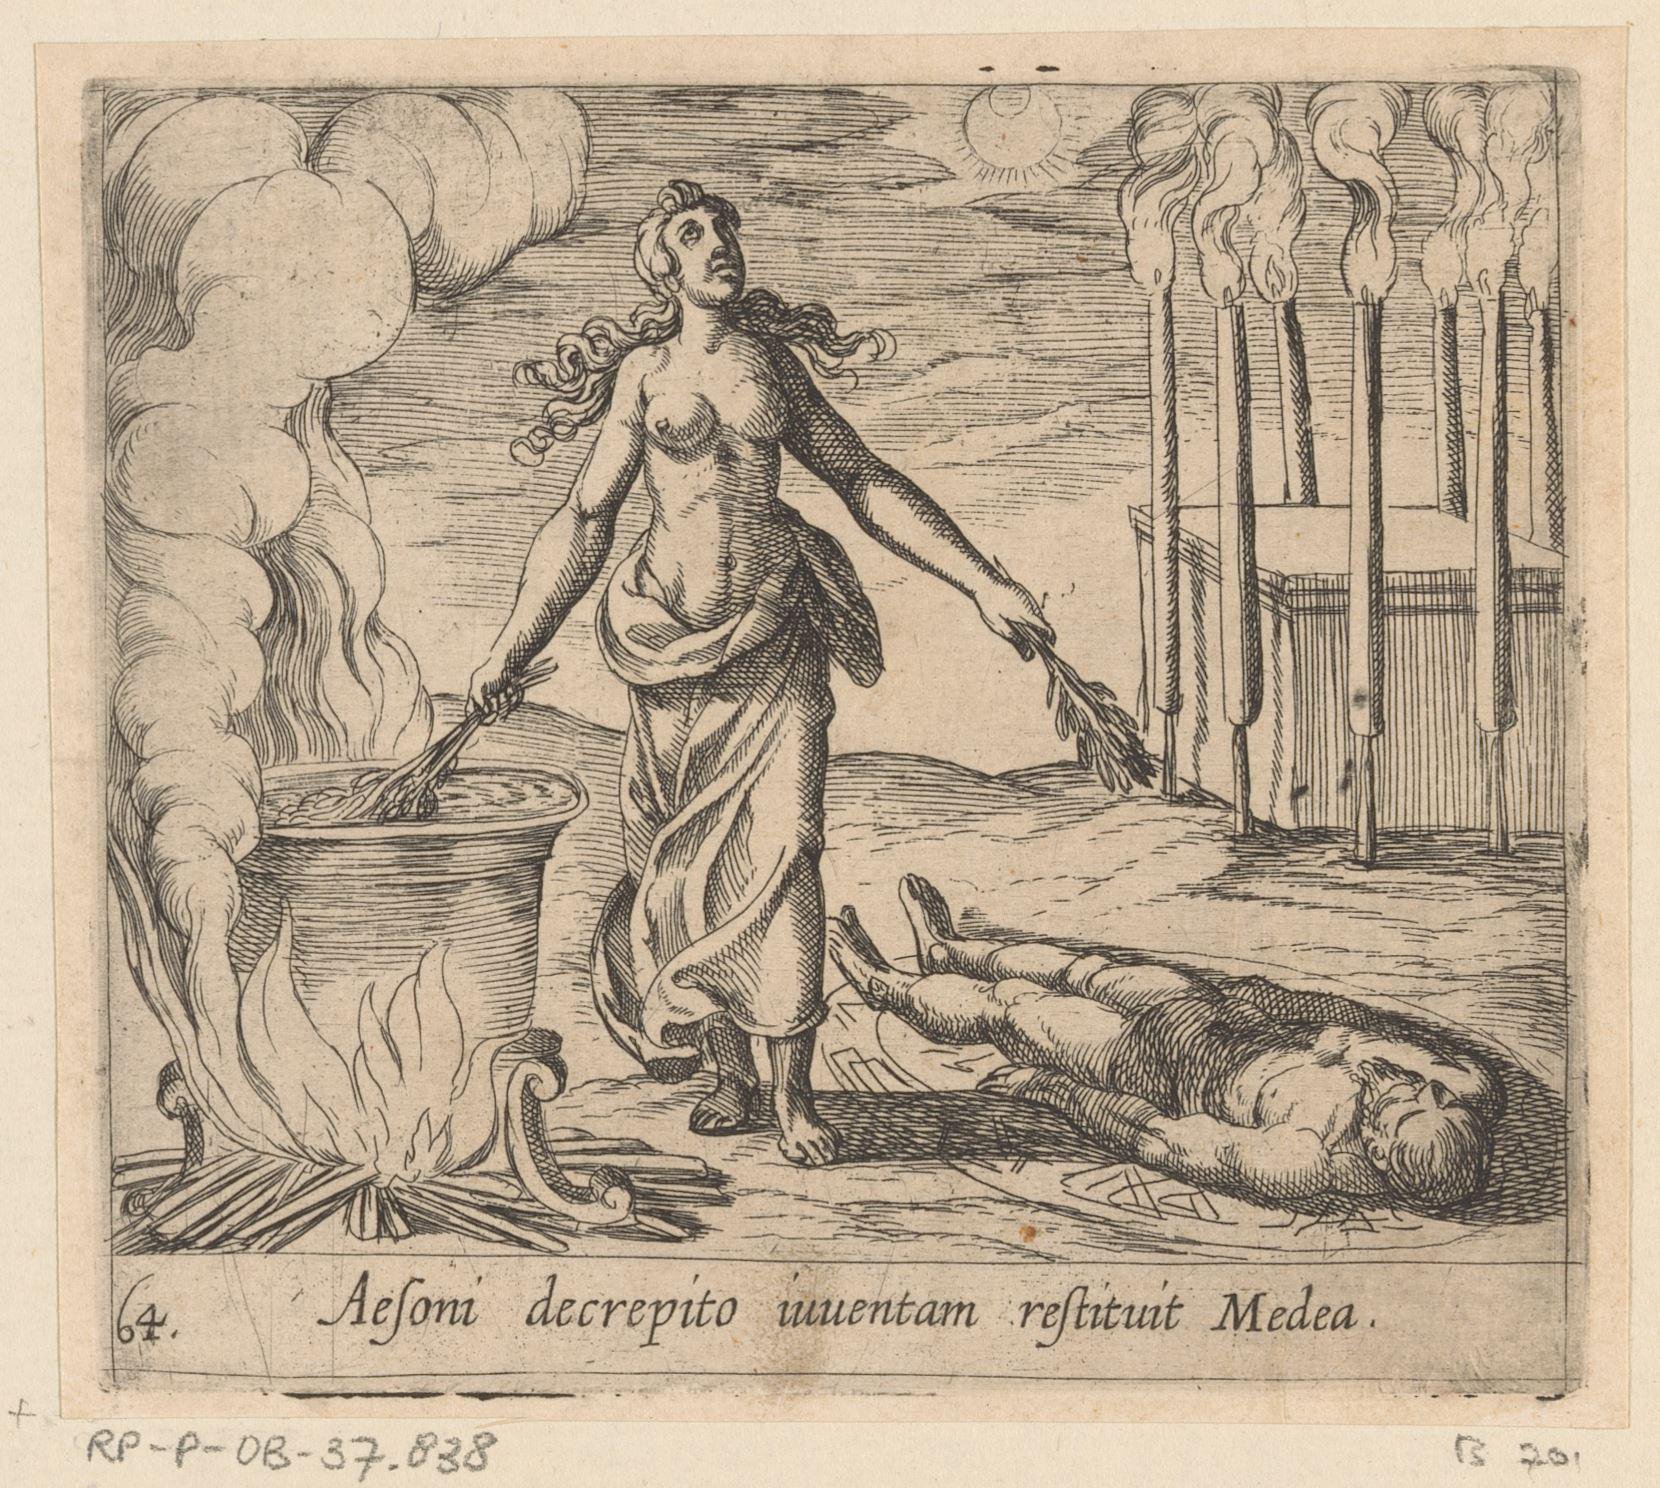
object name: print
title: Aesoni decrepito iuventam restituit Medea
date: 1606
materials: paper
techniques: etching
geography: antwerp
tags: rejuvenation of aeson, aeson is laid down before medea; she brews a potion in a bronze pot (an old and dry olive-branch becomes green when stirred in it)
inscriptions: collector's mark: Lugt 240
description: Aeson ligt voor Medea op de grond. Medea brouwt een toverdrank in een grote ketel. De toverdrank moet de jeugd van Aeson herstellen. Op de achtergrond een altaar dat wordt omringd door brandende toortsen. Titel in het Latijn in ondermarge.